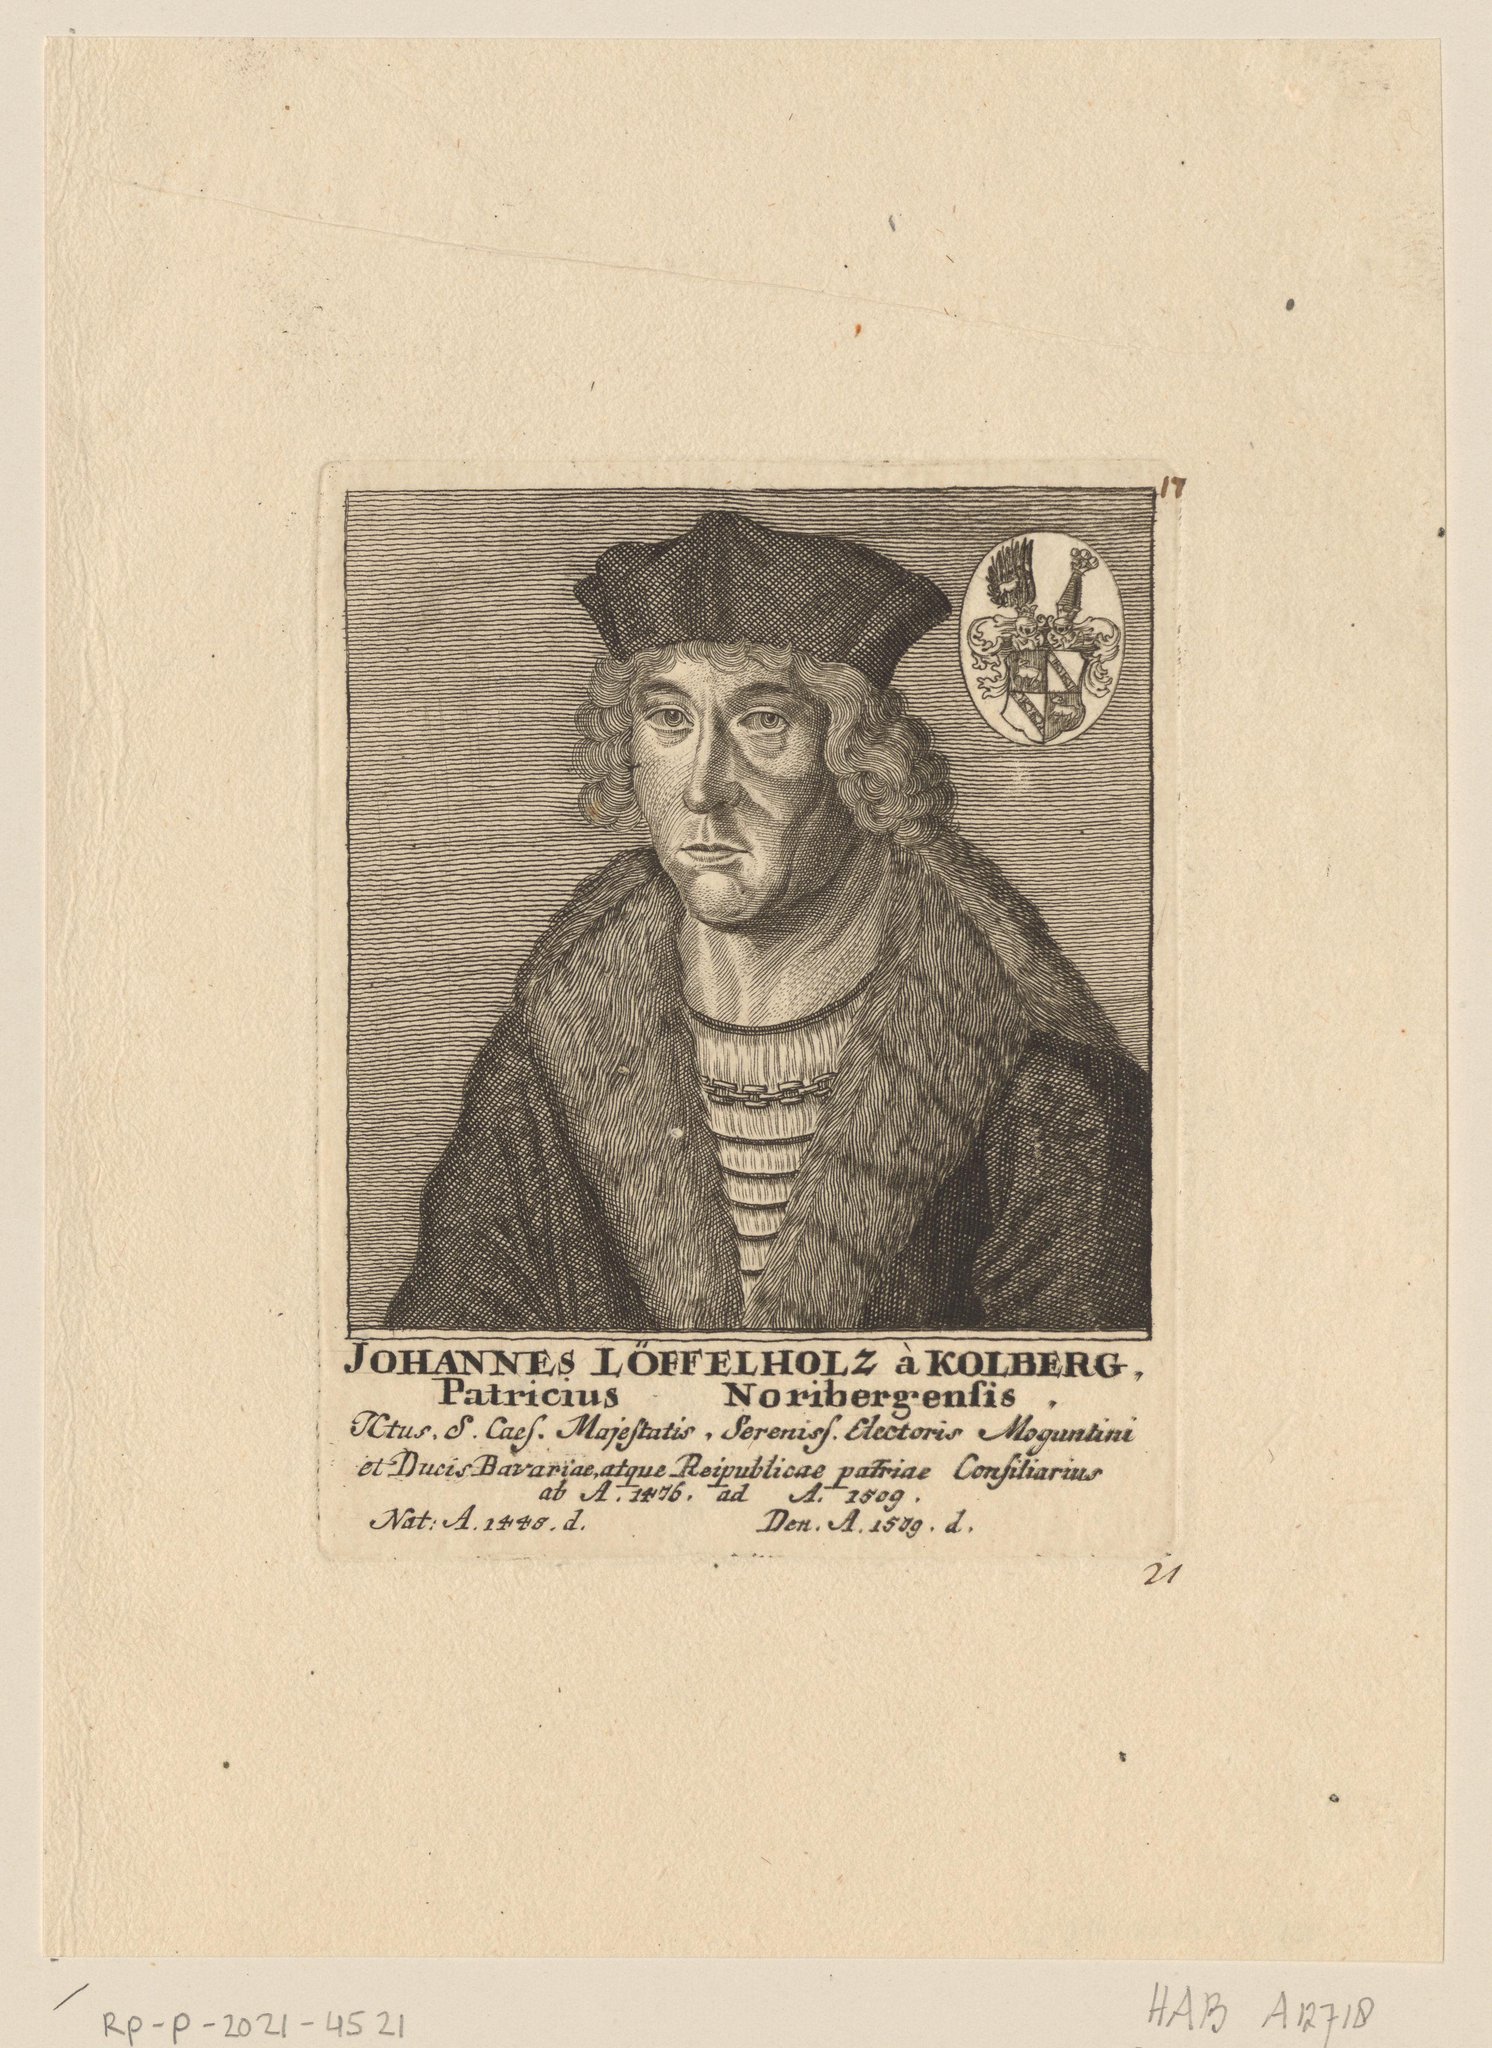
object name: print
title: Portretten van publieke figuren uit Neurenberg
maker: Anonymous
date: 1723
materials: paper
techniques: engraving, etching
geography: germany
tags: historical persons, scholar, philosopher (+ portrait of scholar, scientist), armorial bearing, heraldry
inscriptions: number: ‘21’, number: ‘17’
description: Prent waarschijnlijk uit: Rothscholtz, Friedrich. Icones consiliariorum de illustri republica Noribergensi (...). Neurenberg en Altdorf: erven Johann Daniel Tauber, 1723.